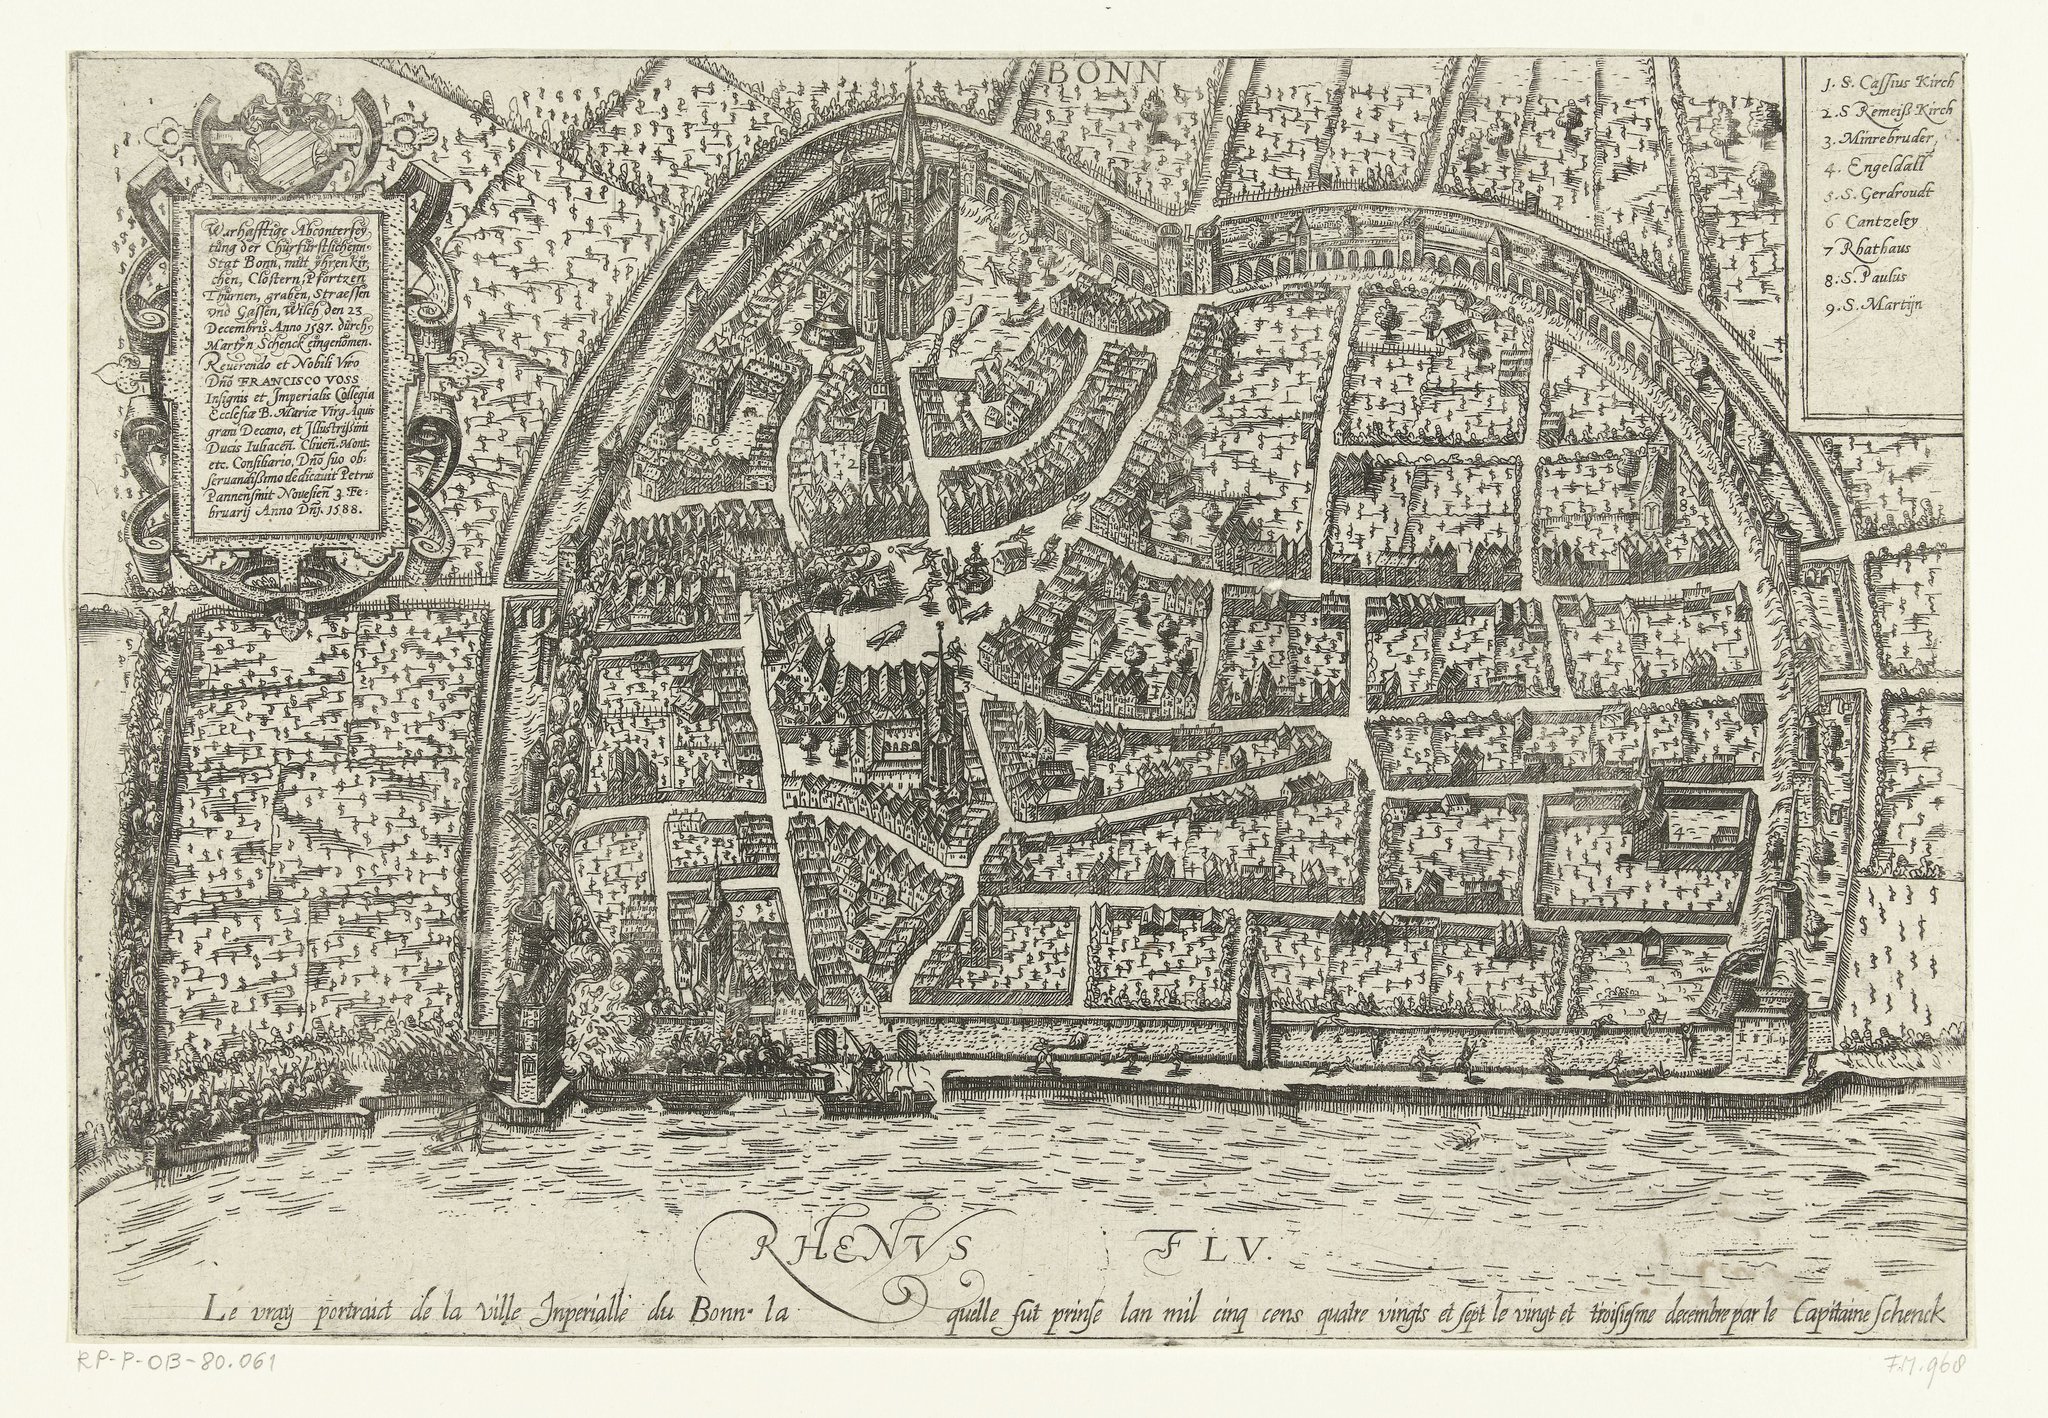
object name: print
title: Bonn door Schenck voor Truchsess gewonnen, 1587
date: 1502-1588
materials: paper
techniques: etching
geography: neuss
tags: nijmegen, capture of city (after the siege), maps of cities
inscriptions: date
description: Plattegrond van de stad Bonn, door Maarten Schenck voor Truchsess gewonnen, 23 december 1587. Episode uit de Keulse Oorlog. Linksboven een cartouche met opschrift van 18 regels in het Duits, rechtsboven de legenda 1-9 in het Duits.